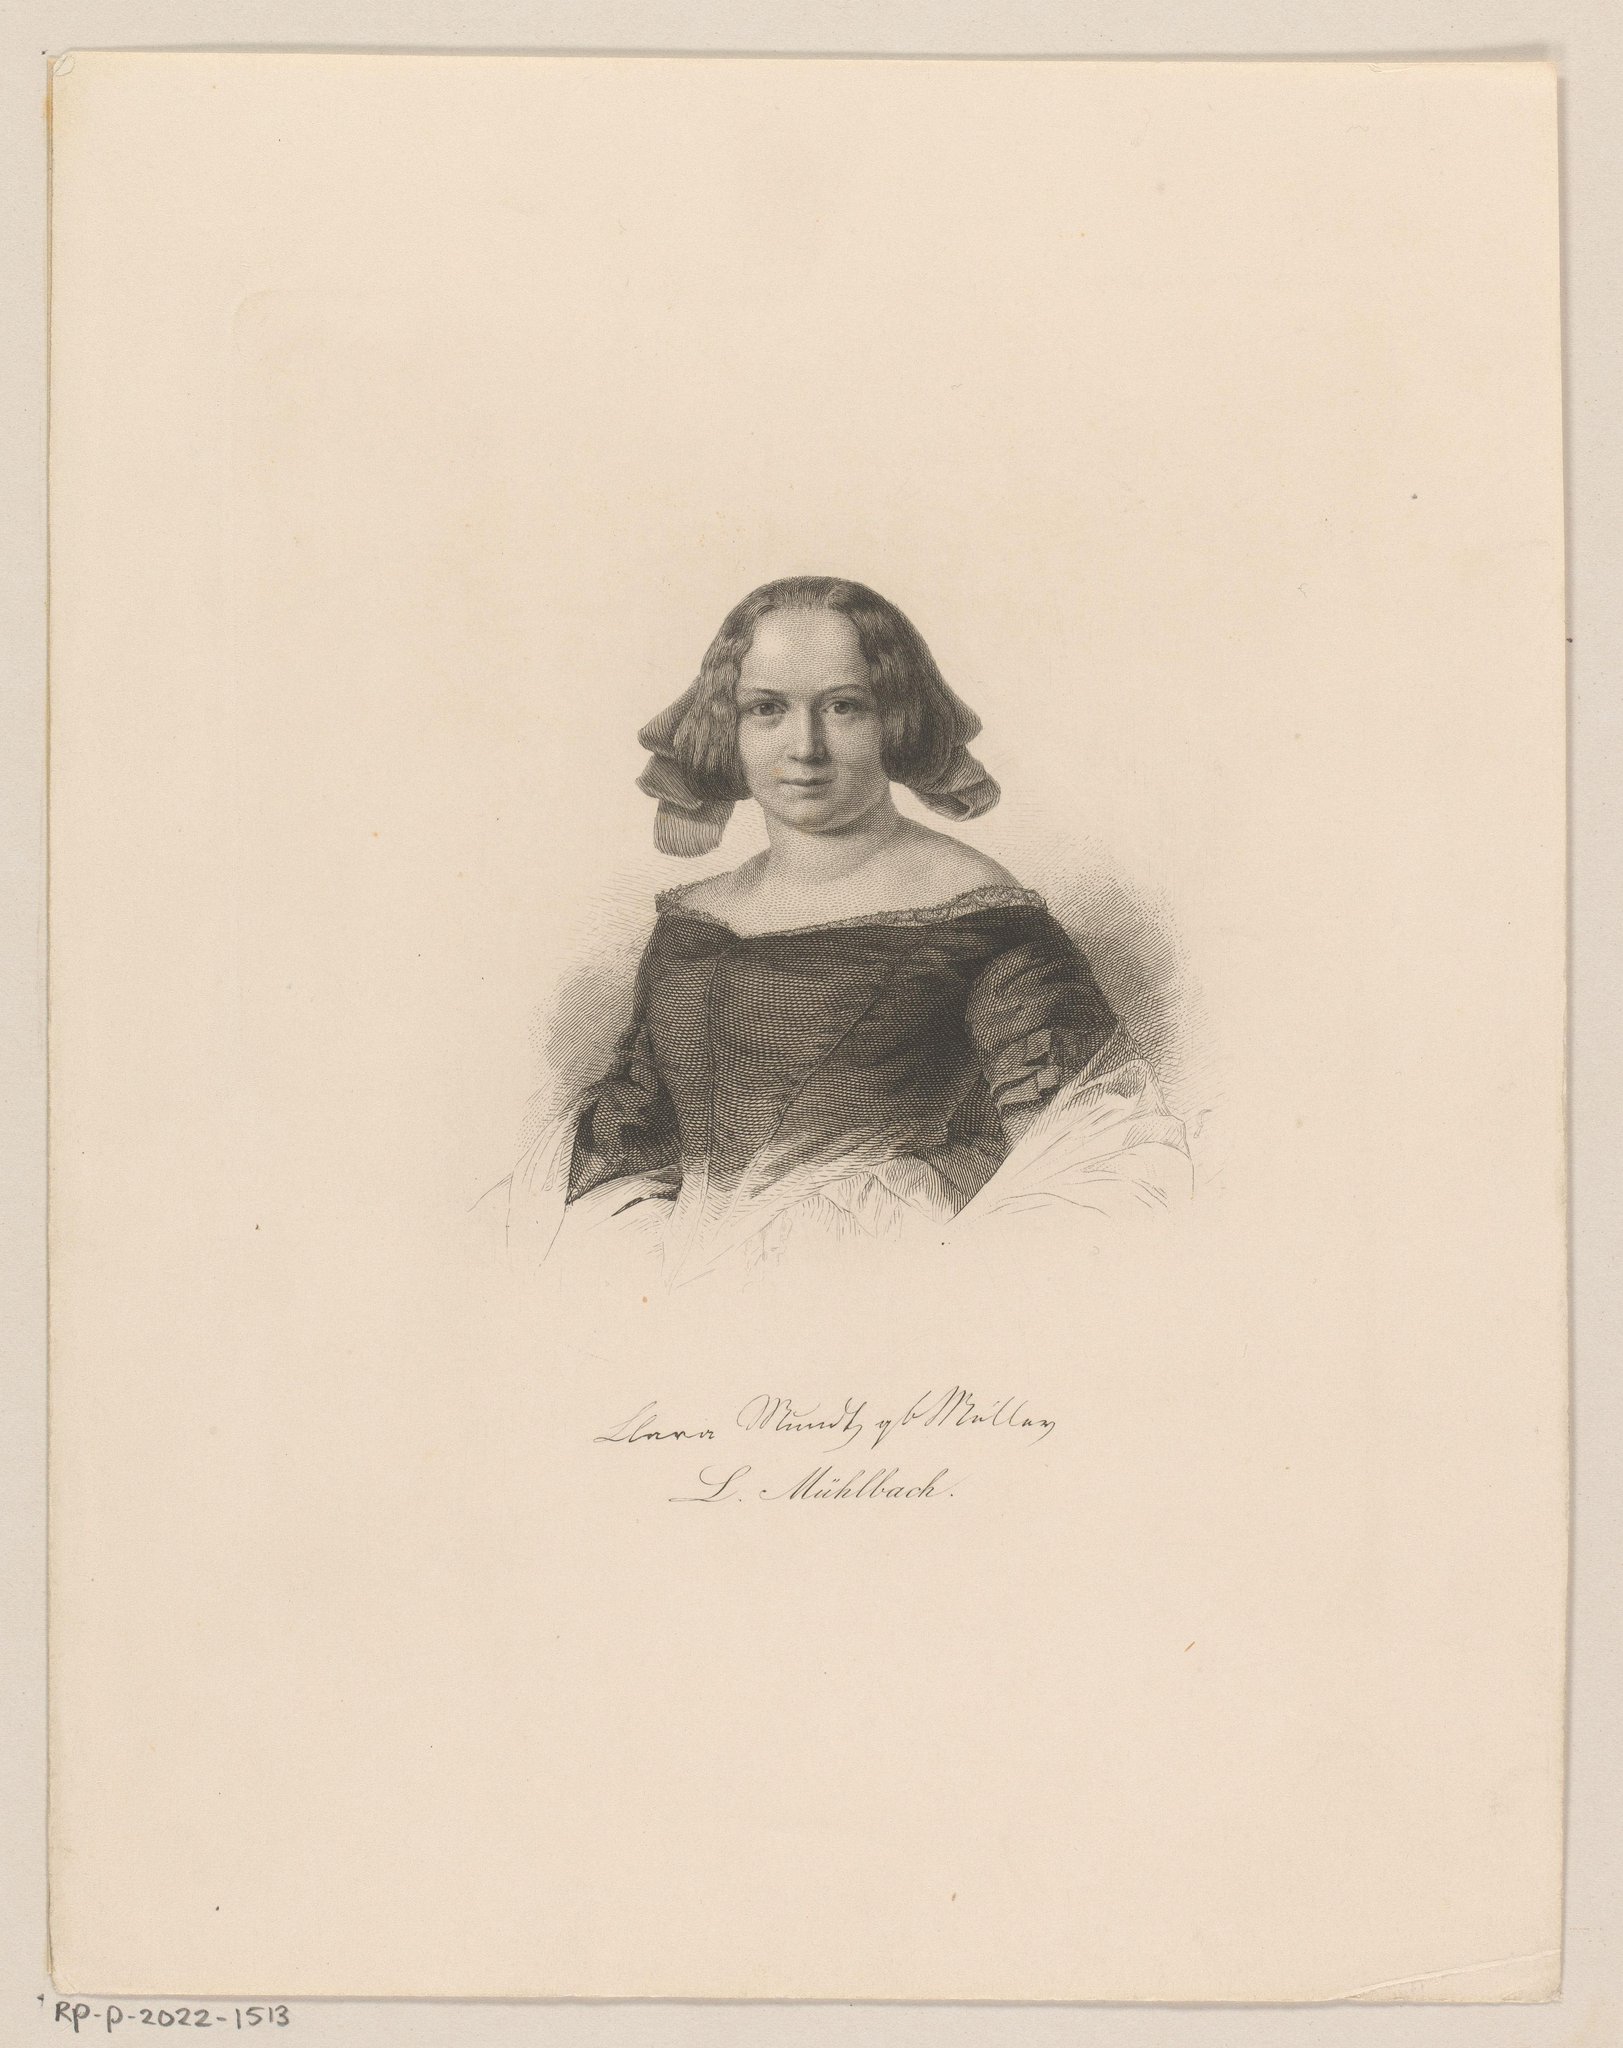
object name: print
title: Portret van Luise Mühlbach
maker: Anonymous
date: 1839-1900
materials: paper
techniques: engraving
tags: berlin, louise mühlbach, historical persons - bb - woman, portrait of a writer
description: Met facsimile signatuur van de geportretteerde.